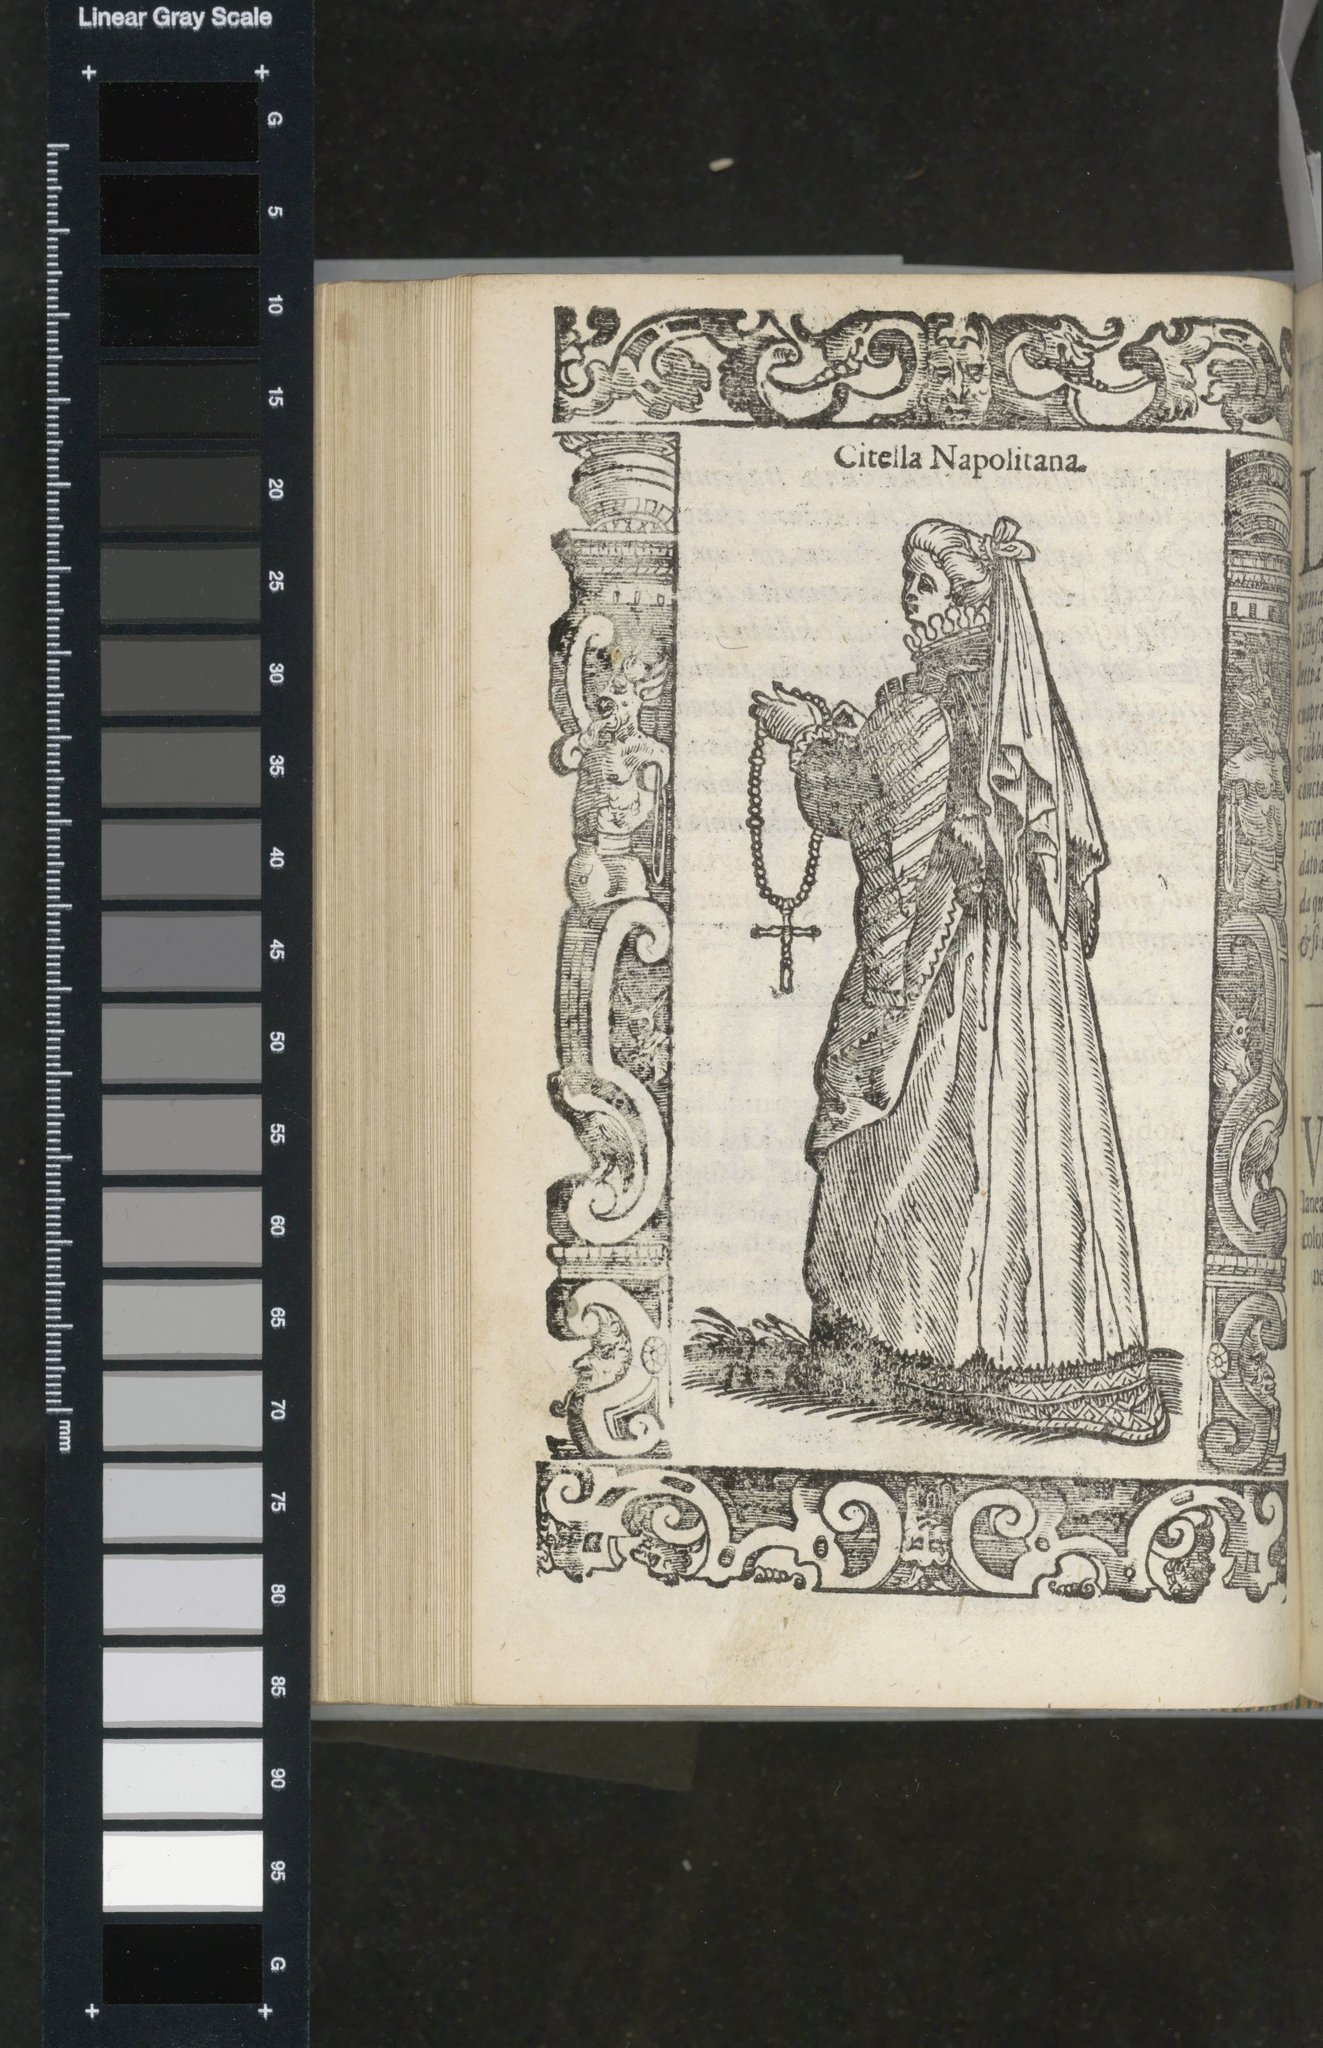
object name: costume print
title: Citella Napolitana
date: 1598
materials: paper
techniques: woodcut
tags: veil (+ women's clothes), aids for prayer, e.g. rosary, fashion plates, dress, gown (+ women's clothes)